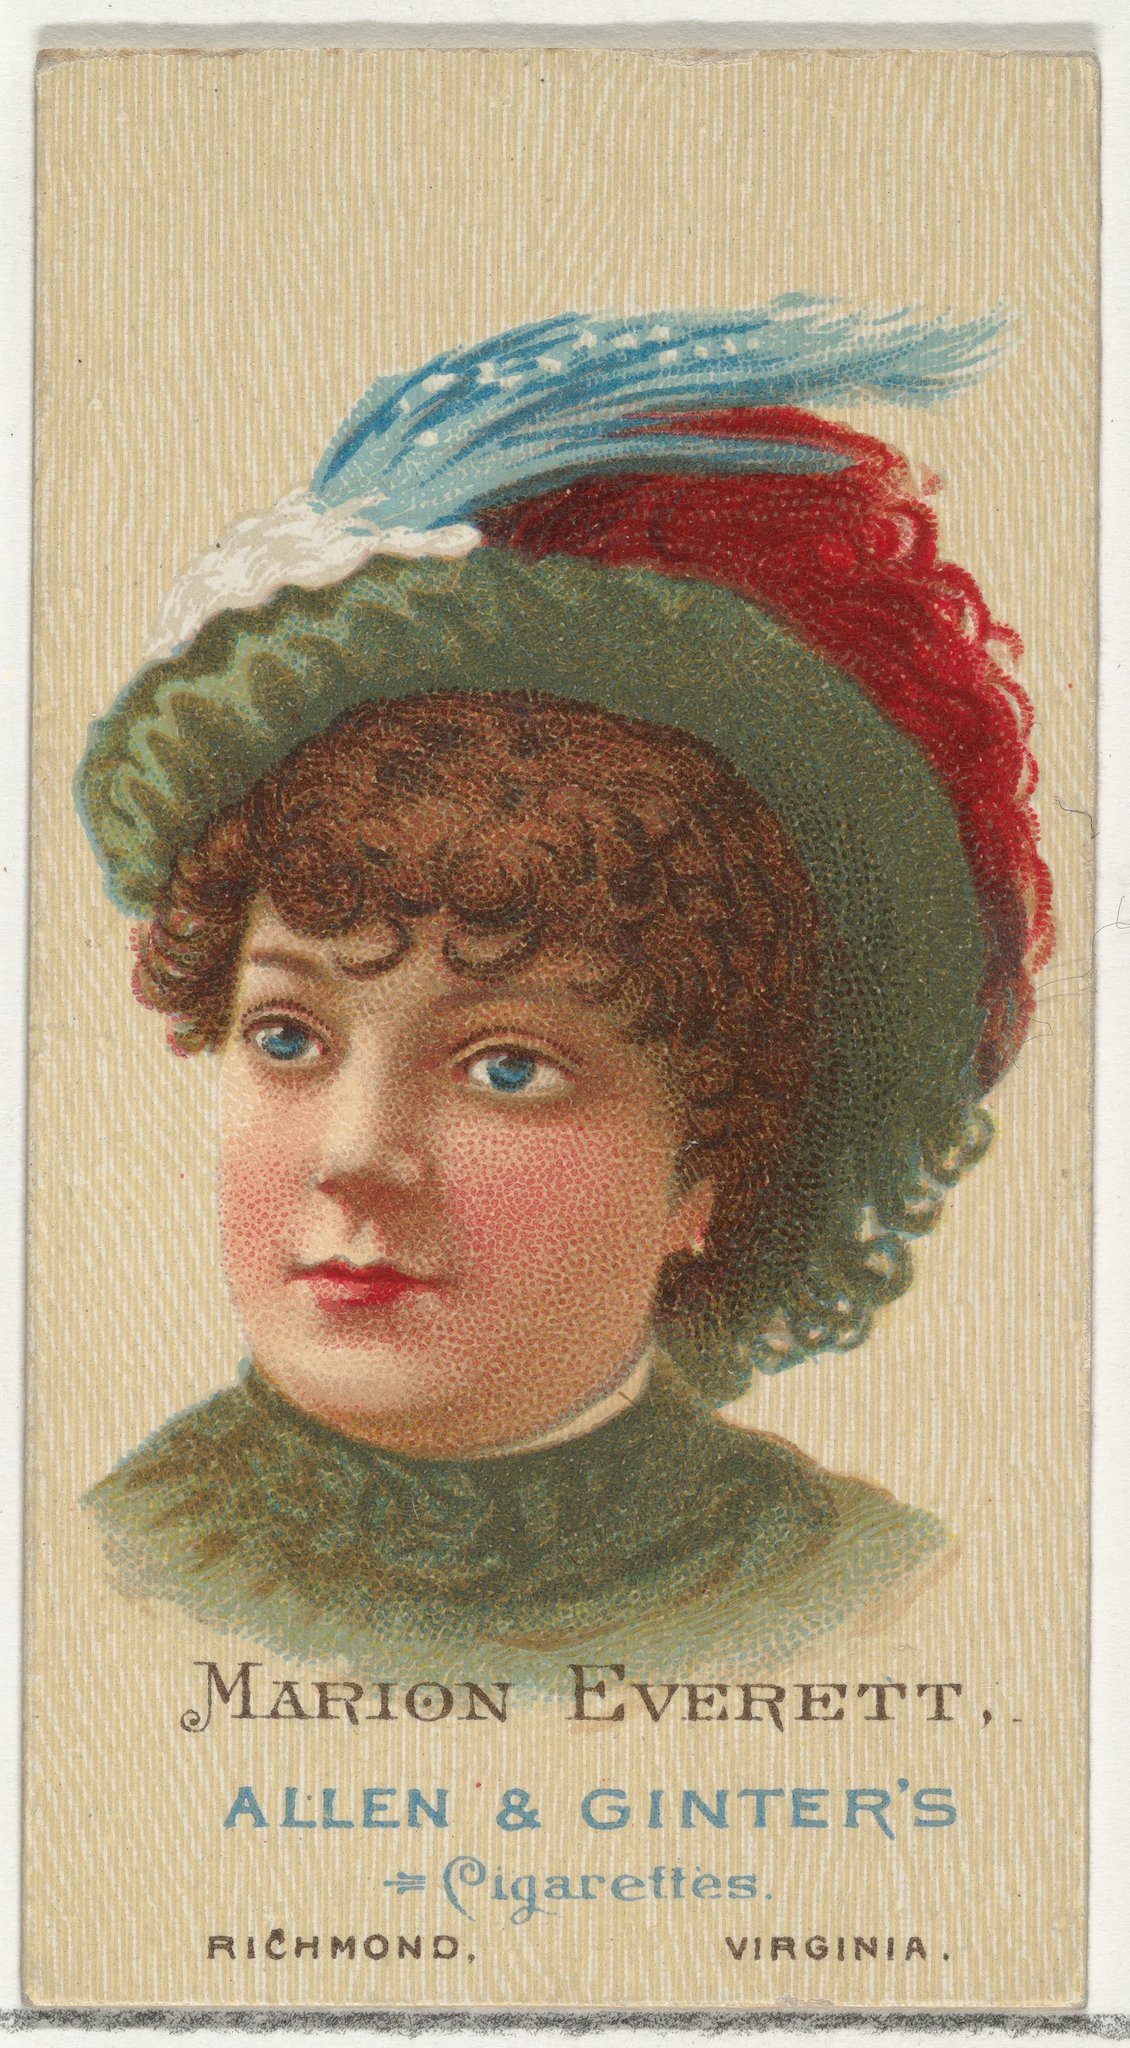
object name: print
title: Marion Everett, from World's Beauties, Series 2 (N27) for Allen & Ginter Cigarettes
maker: allen & ginter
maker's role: publisher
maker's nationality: american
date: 1888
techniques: color lithograph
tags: women